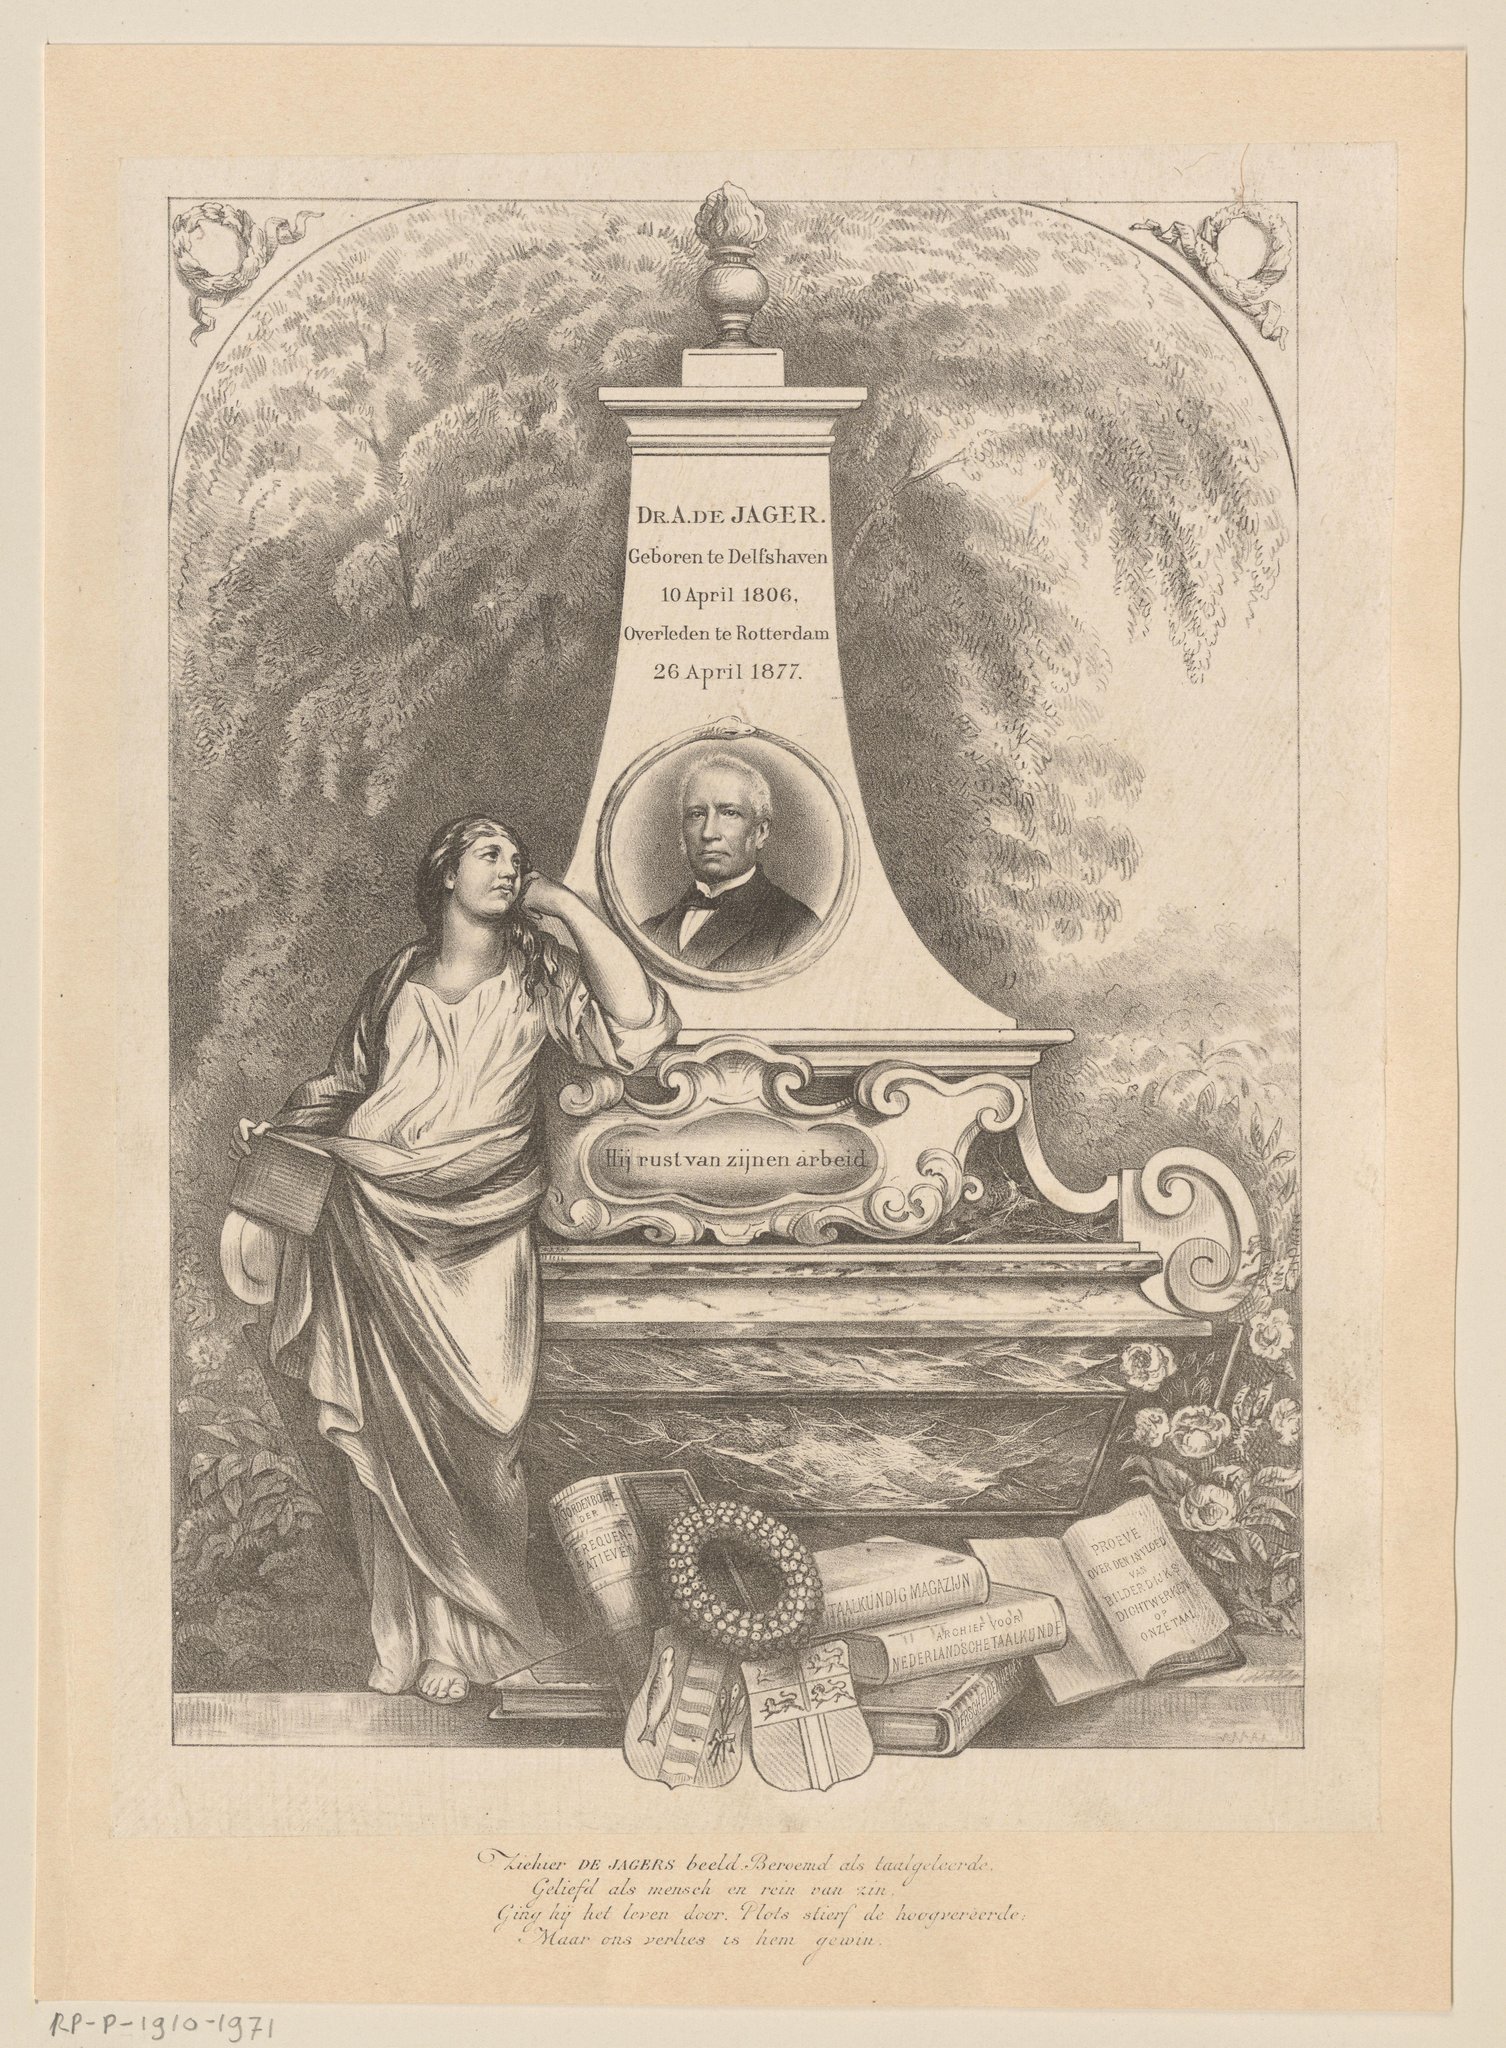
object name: print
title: Monument met het portret van Arie de Jager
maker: pieter wilhelmus van de weijer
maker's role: print maker, printer, publisher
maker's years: 1816-1880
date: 1877-1899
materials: paper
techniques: lithograph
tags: delfshaven, rotterdam, linguistics, historical persons, grave, tomb, book, armorial bearing, heraldry, abstract ideas and concepts (+ personification)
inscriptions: collector's mark: Lugt 2228